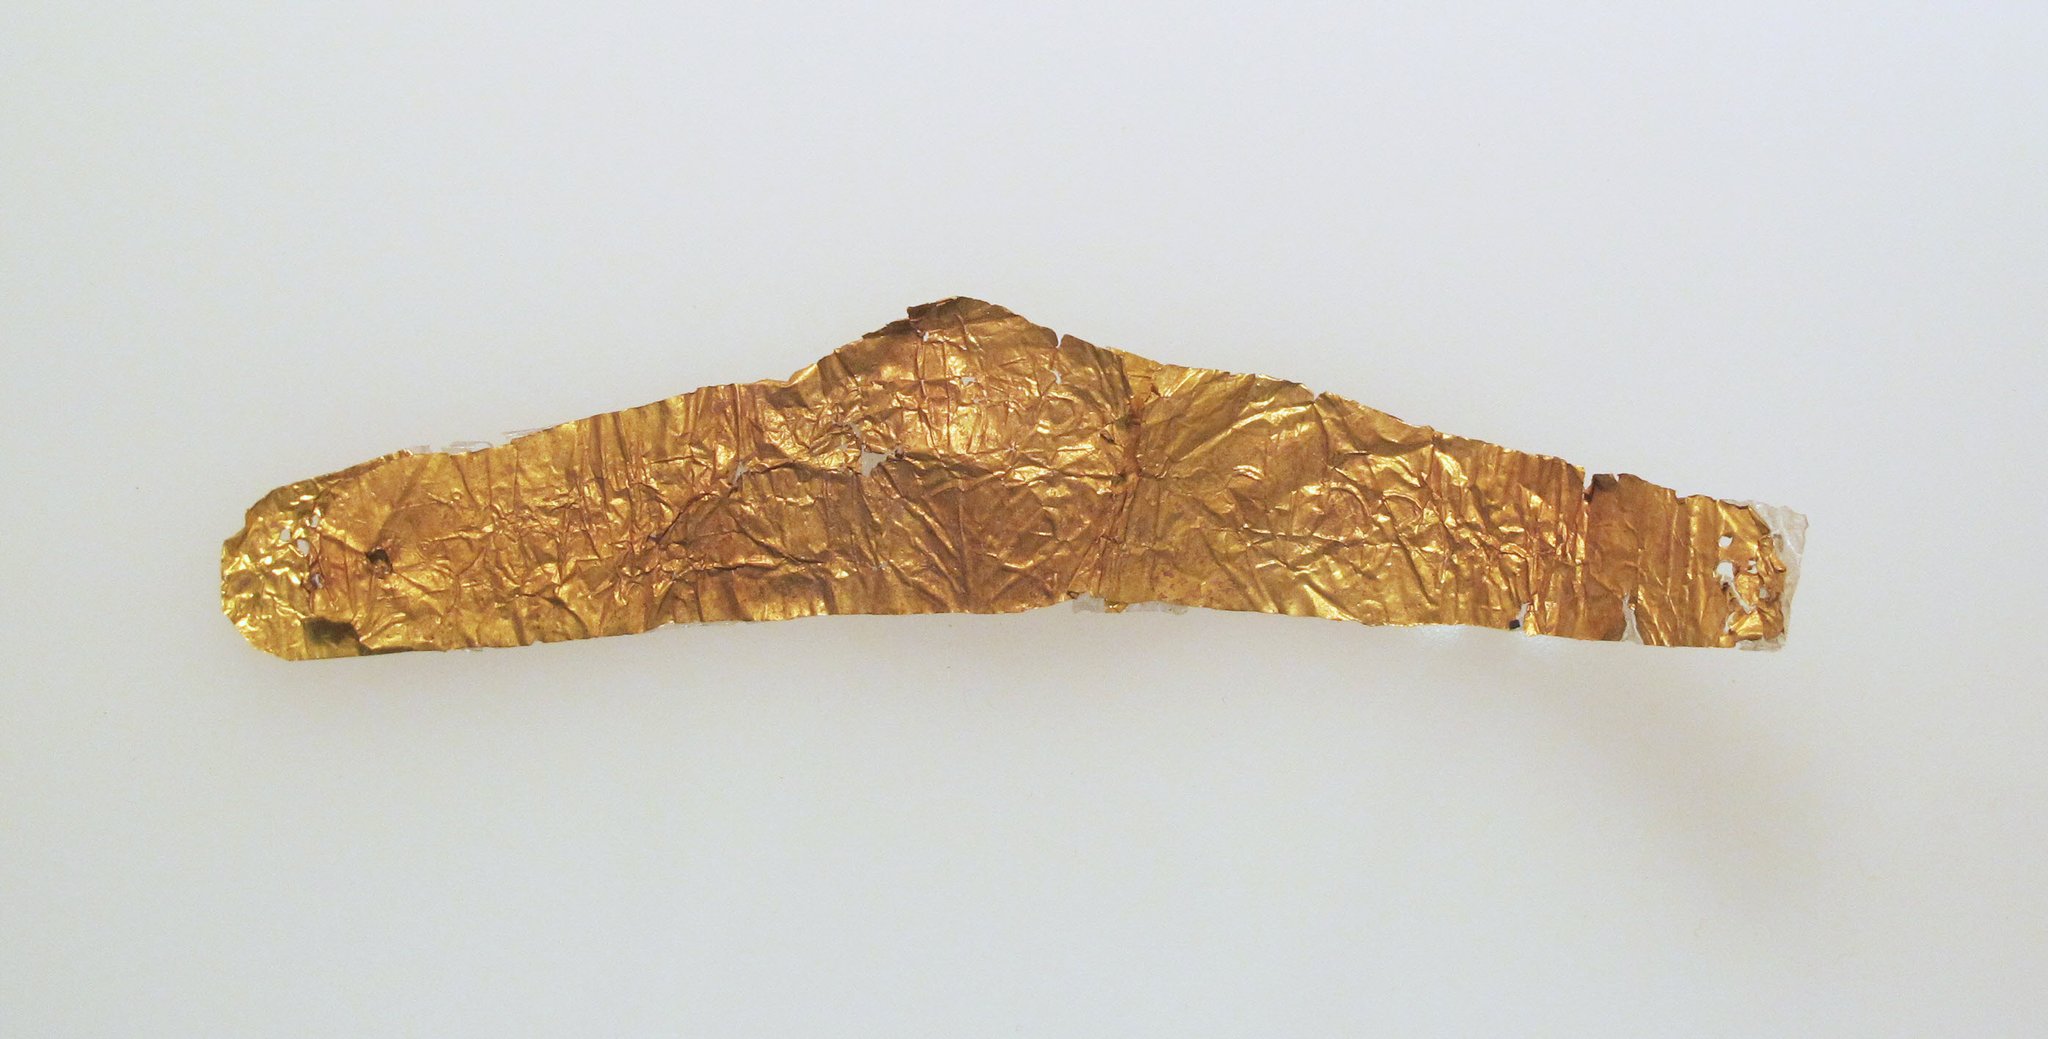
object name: frontlet of gold leaf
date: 7000 BCE-330 CE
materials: gold